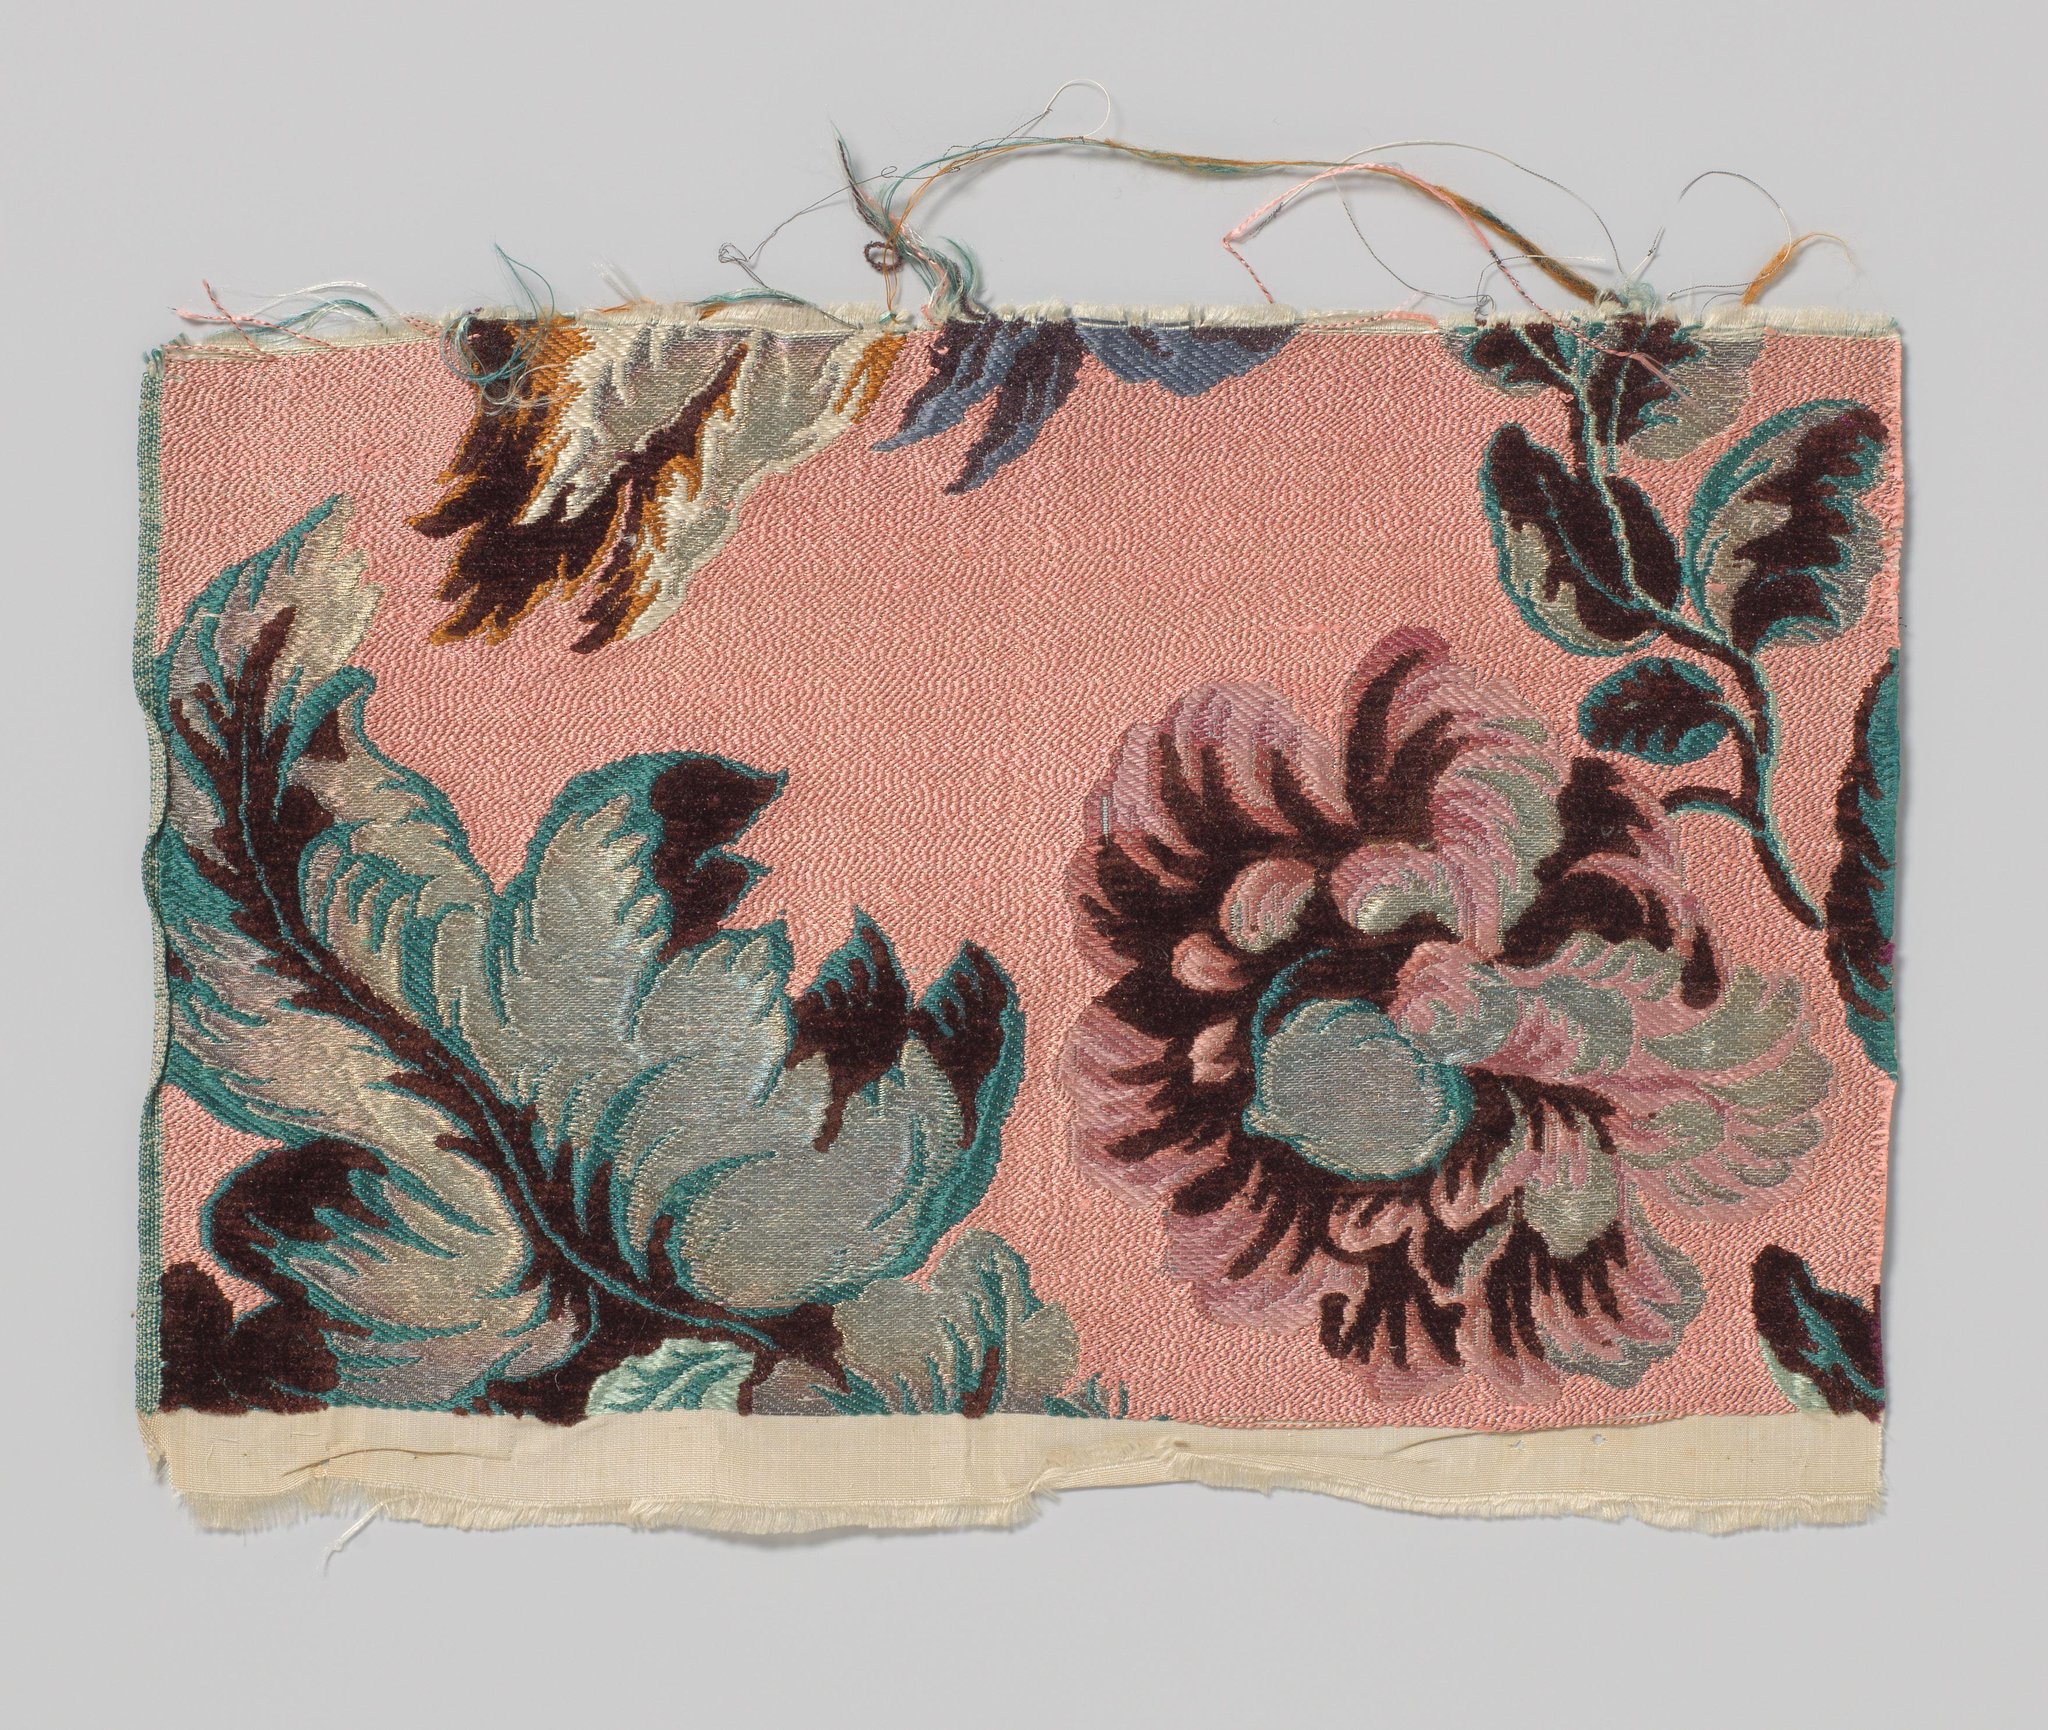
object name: silk textile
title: Fragment zijdeweefsel met op roze fond een grote papaver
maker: Anonymous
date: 1735-1740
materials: metal thread, silk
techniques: brocade, weave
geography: france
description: Fragment zijdeweefsel met een onvolledig, asymmetrisch patroon: aan een dunne golvende tak groeit een papaver met knopvormig hart van turkoois-groen en bloembladeren in zilver, roze en lila met schaduwen van aubergine chenille. Rechts (afgesneden en een linkse herhaling terug te vinden) een groot ingesneden blad van zilver met turkoois-groene randen en aubergine schaduw van chenille. Afgesneden: een andere bloem onder andere in crême, wit, roestkleur, staalblauw en donkerblauwe chenille.